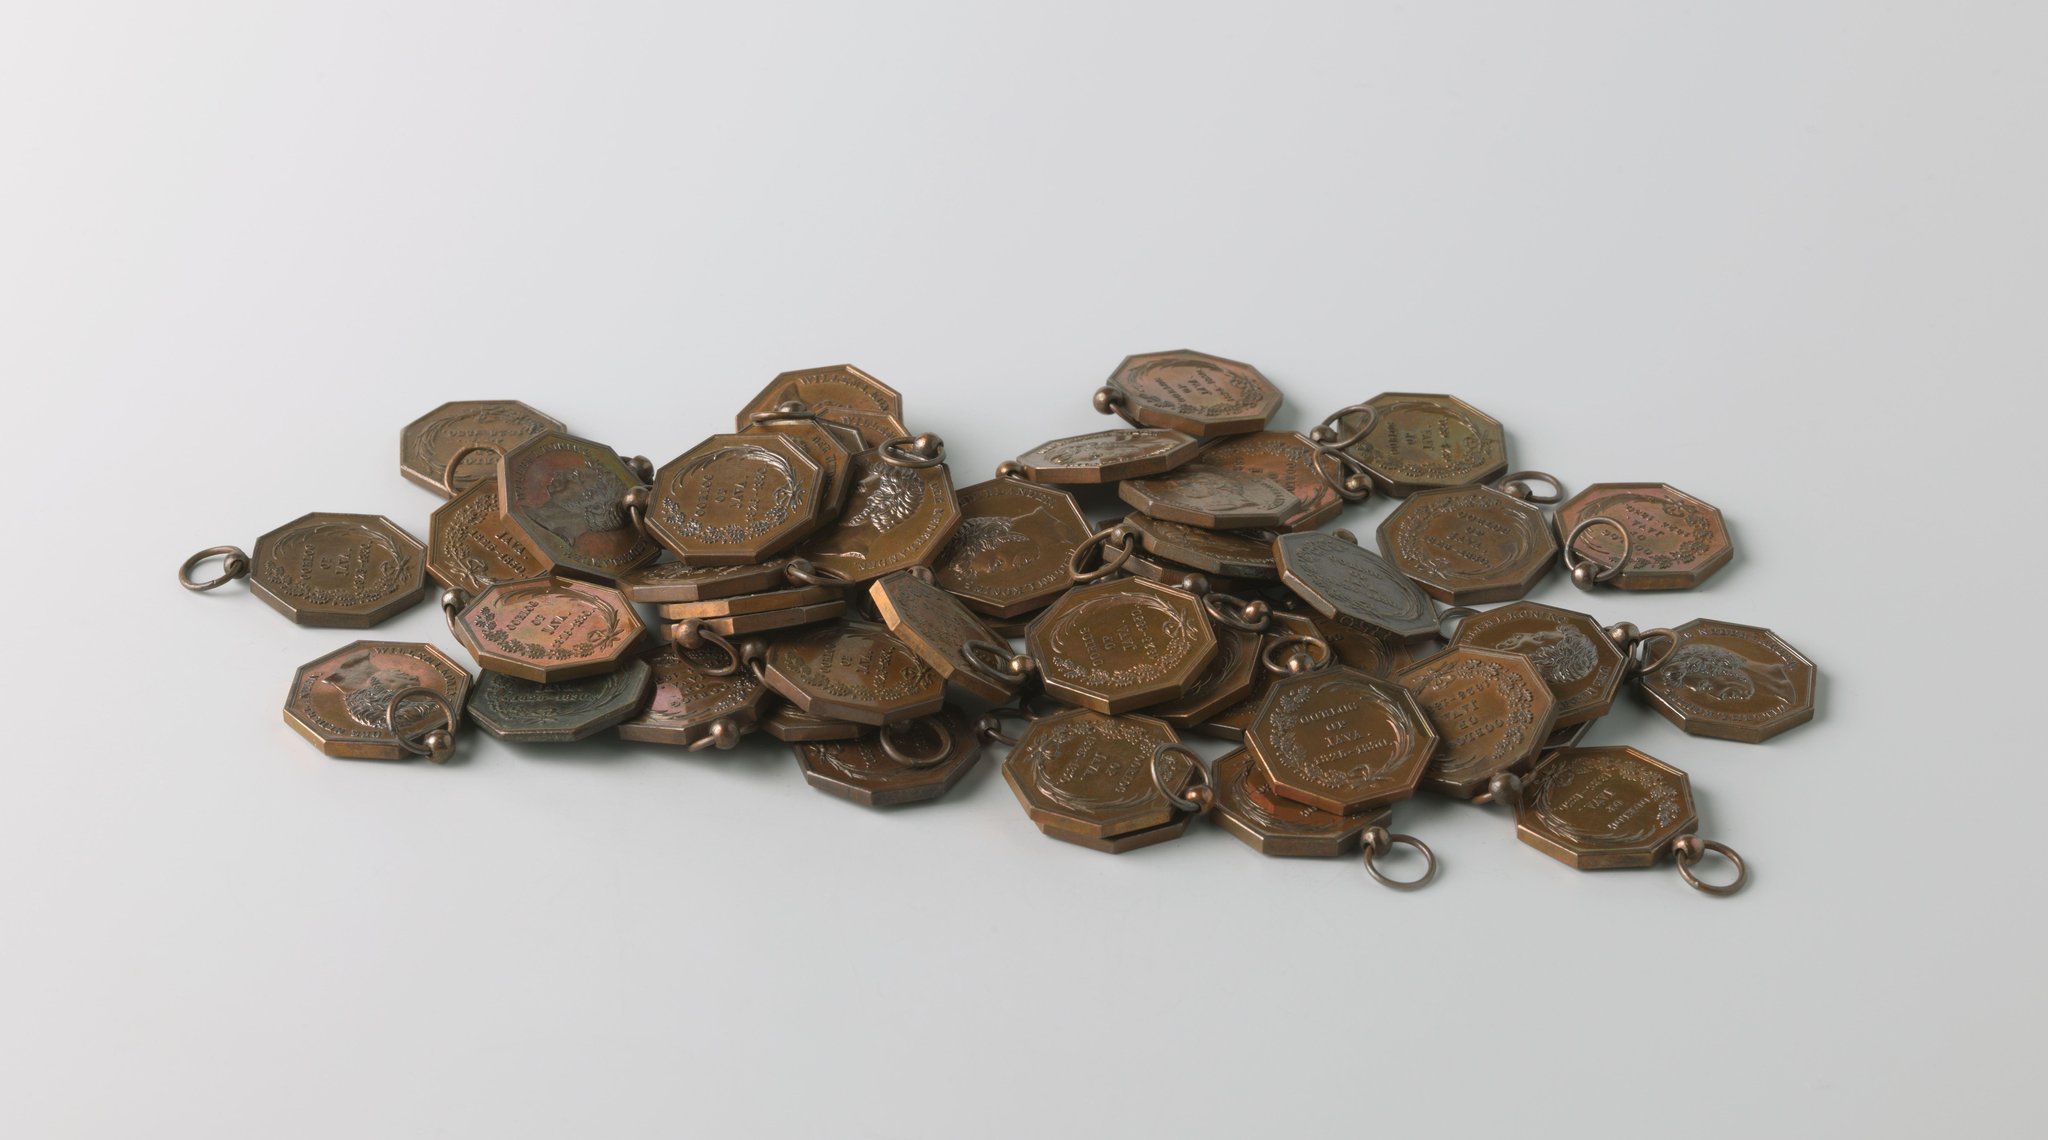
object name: insignia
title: Oorlog op Java, groot draagteken uitgereikt aan de deelnemers, ter ere van Willem I Frederik, koning der Nederlanden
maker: david van der kellen (1804-1879)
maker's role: die cutter, draughtsman, print maker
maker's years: 1804-1879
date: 1830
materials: bronze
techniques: striking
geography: utrecht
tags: the hague, berlin, william i of the netherlands, java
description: Achthoekig draagteken aan draagoog en draagring. Voorzijde: borststuk man binnen omschrift. Keerzijde: opschrift binnen tot krans samengebonden palm- en eiketak; twee aan draaglint.